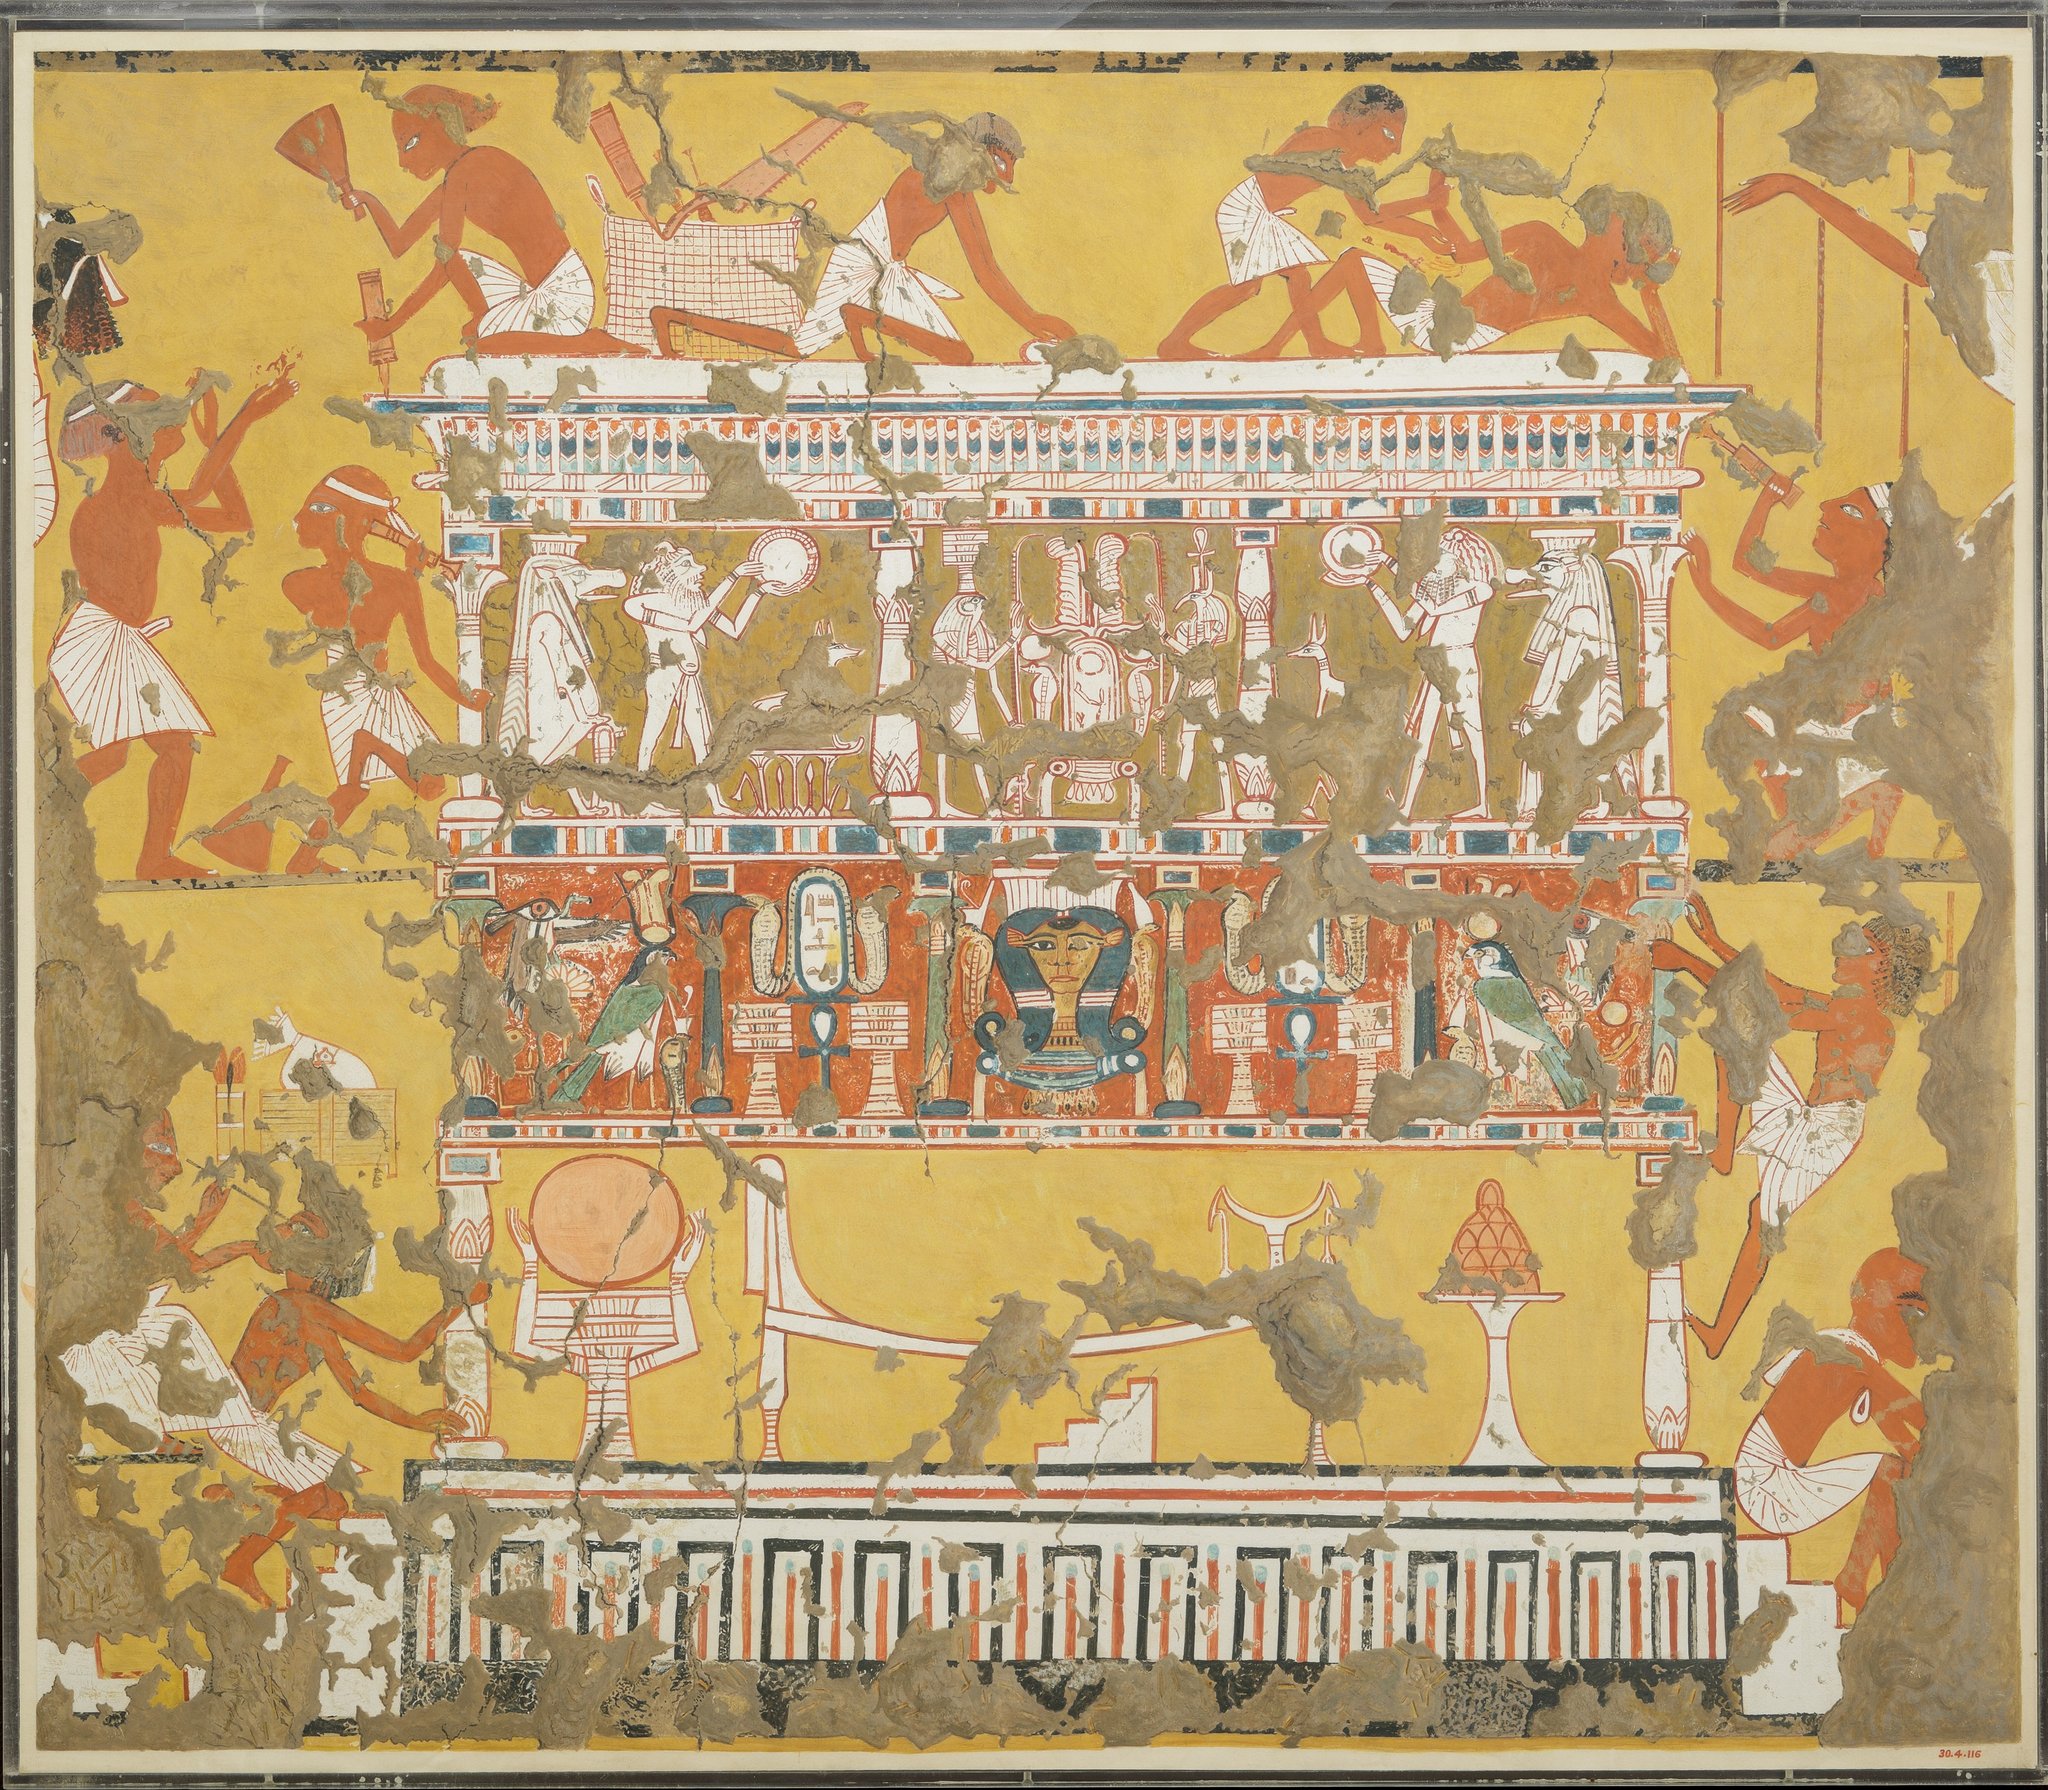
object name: facsimile, ipuy tt 217, catafalque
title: Building a Catafalque, Tomb of Ipuy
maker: norman de garis davies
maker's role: artist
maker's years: 1865-1941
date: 1279-1213 BCE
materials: paper, paint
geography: egypt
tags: men,working